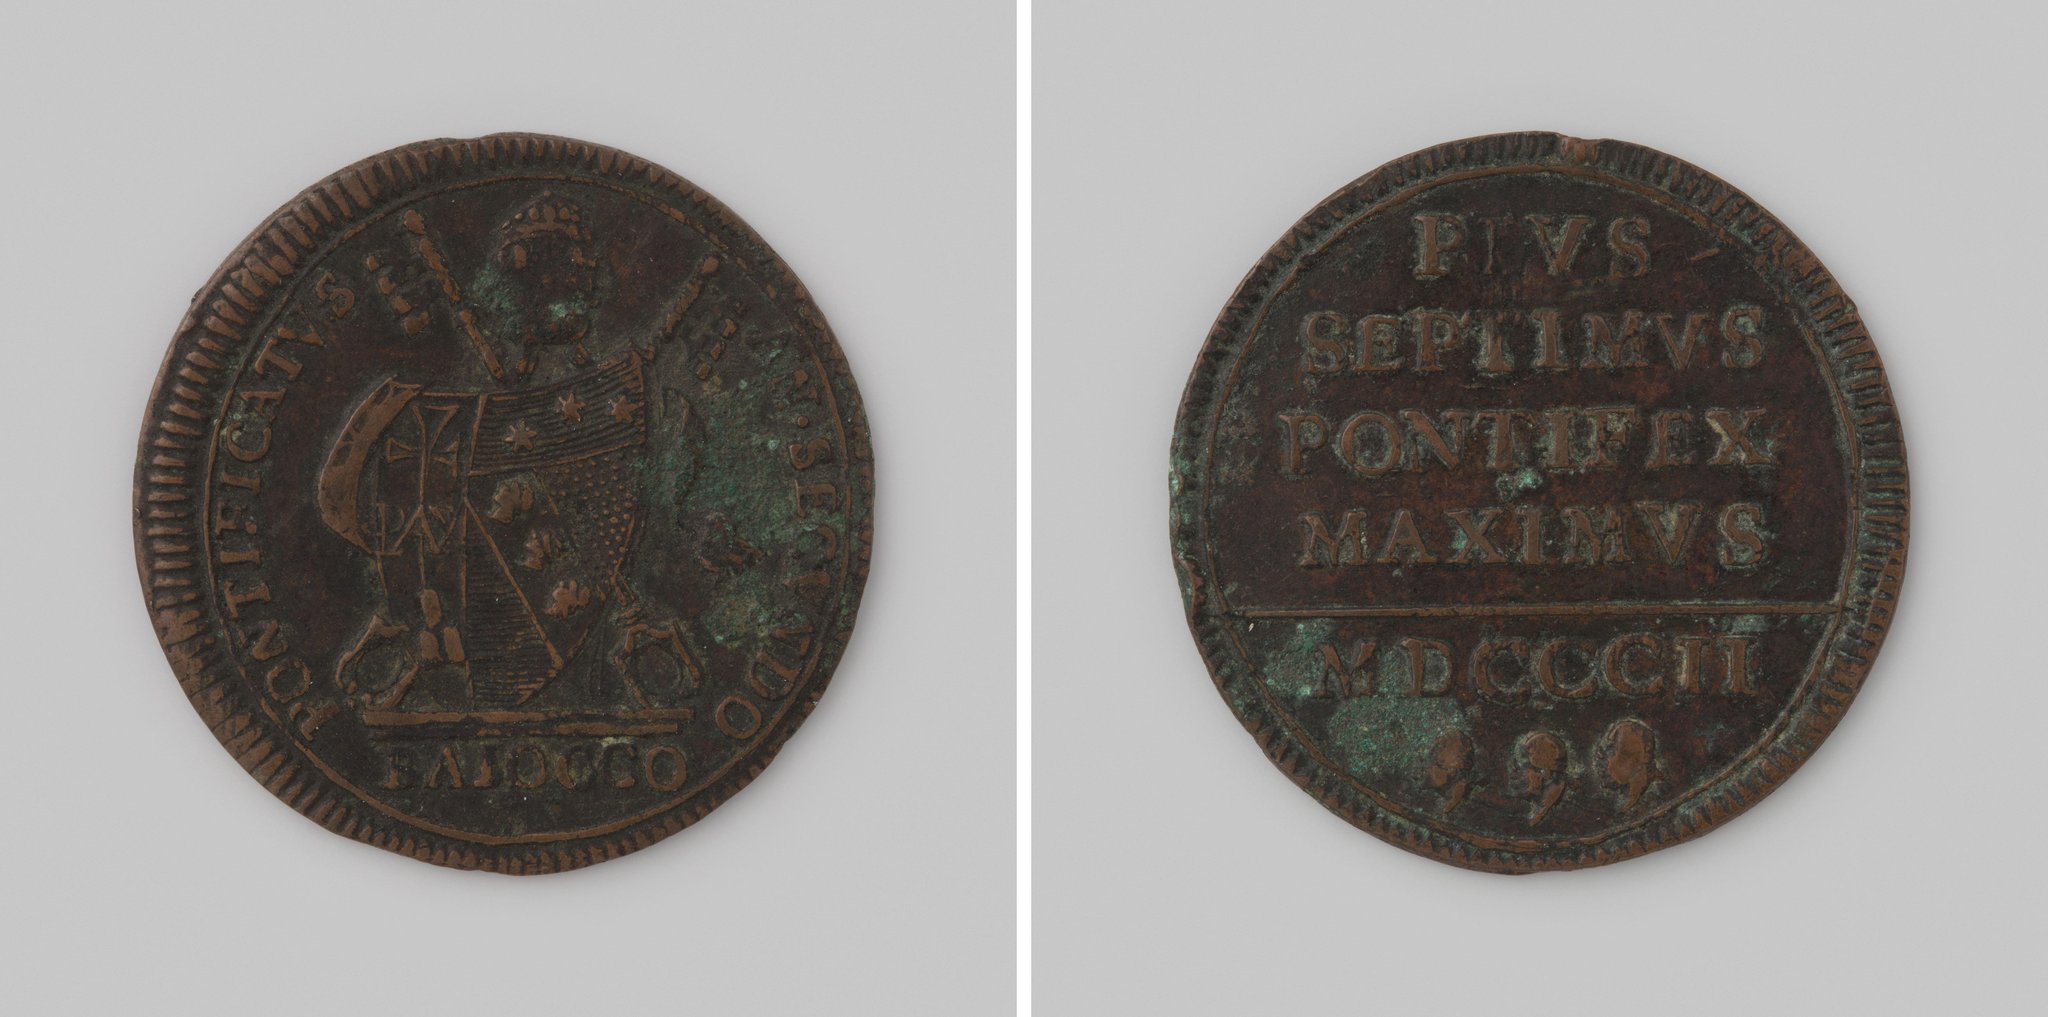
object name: coin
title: Baiocco uit de kerkelijke Staat van paus Pius VII, 1802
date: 1802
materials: copper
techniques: striking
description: Koperen munt. Voorzijde: op twee gekruiste sleutels versierd wapenschild, waarboven tiara. Waarde-aanduiding in afsnede. Keerzijde: opschrift in vier regels. In afsnede jaartal, waaronder drie hoofden. Gladde rand.